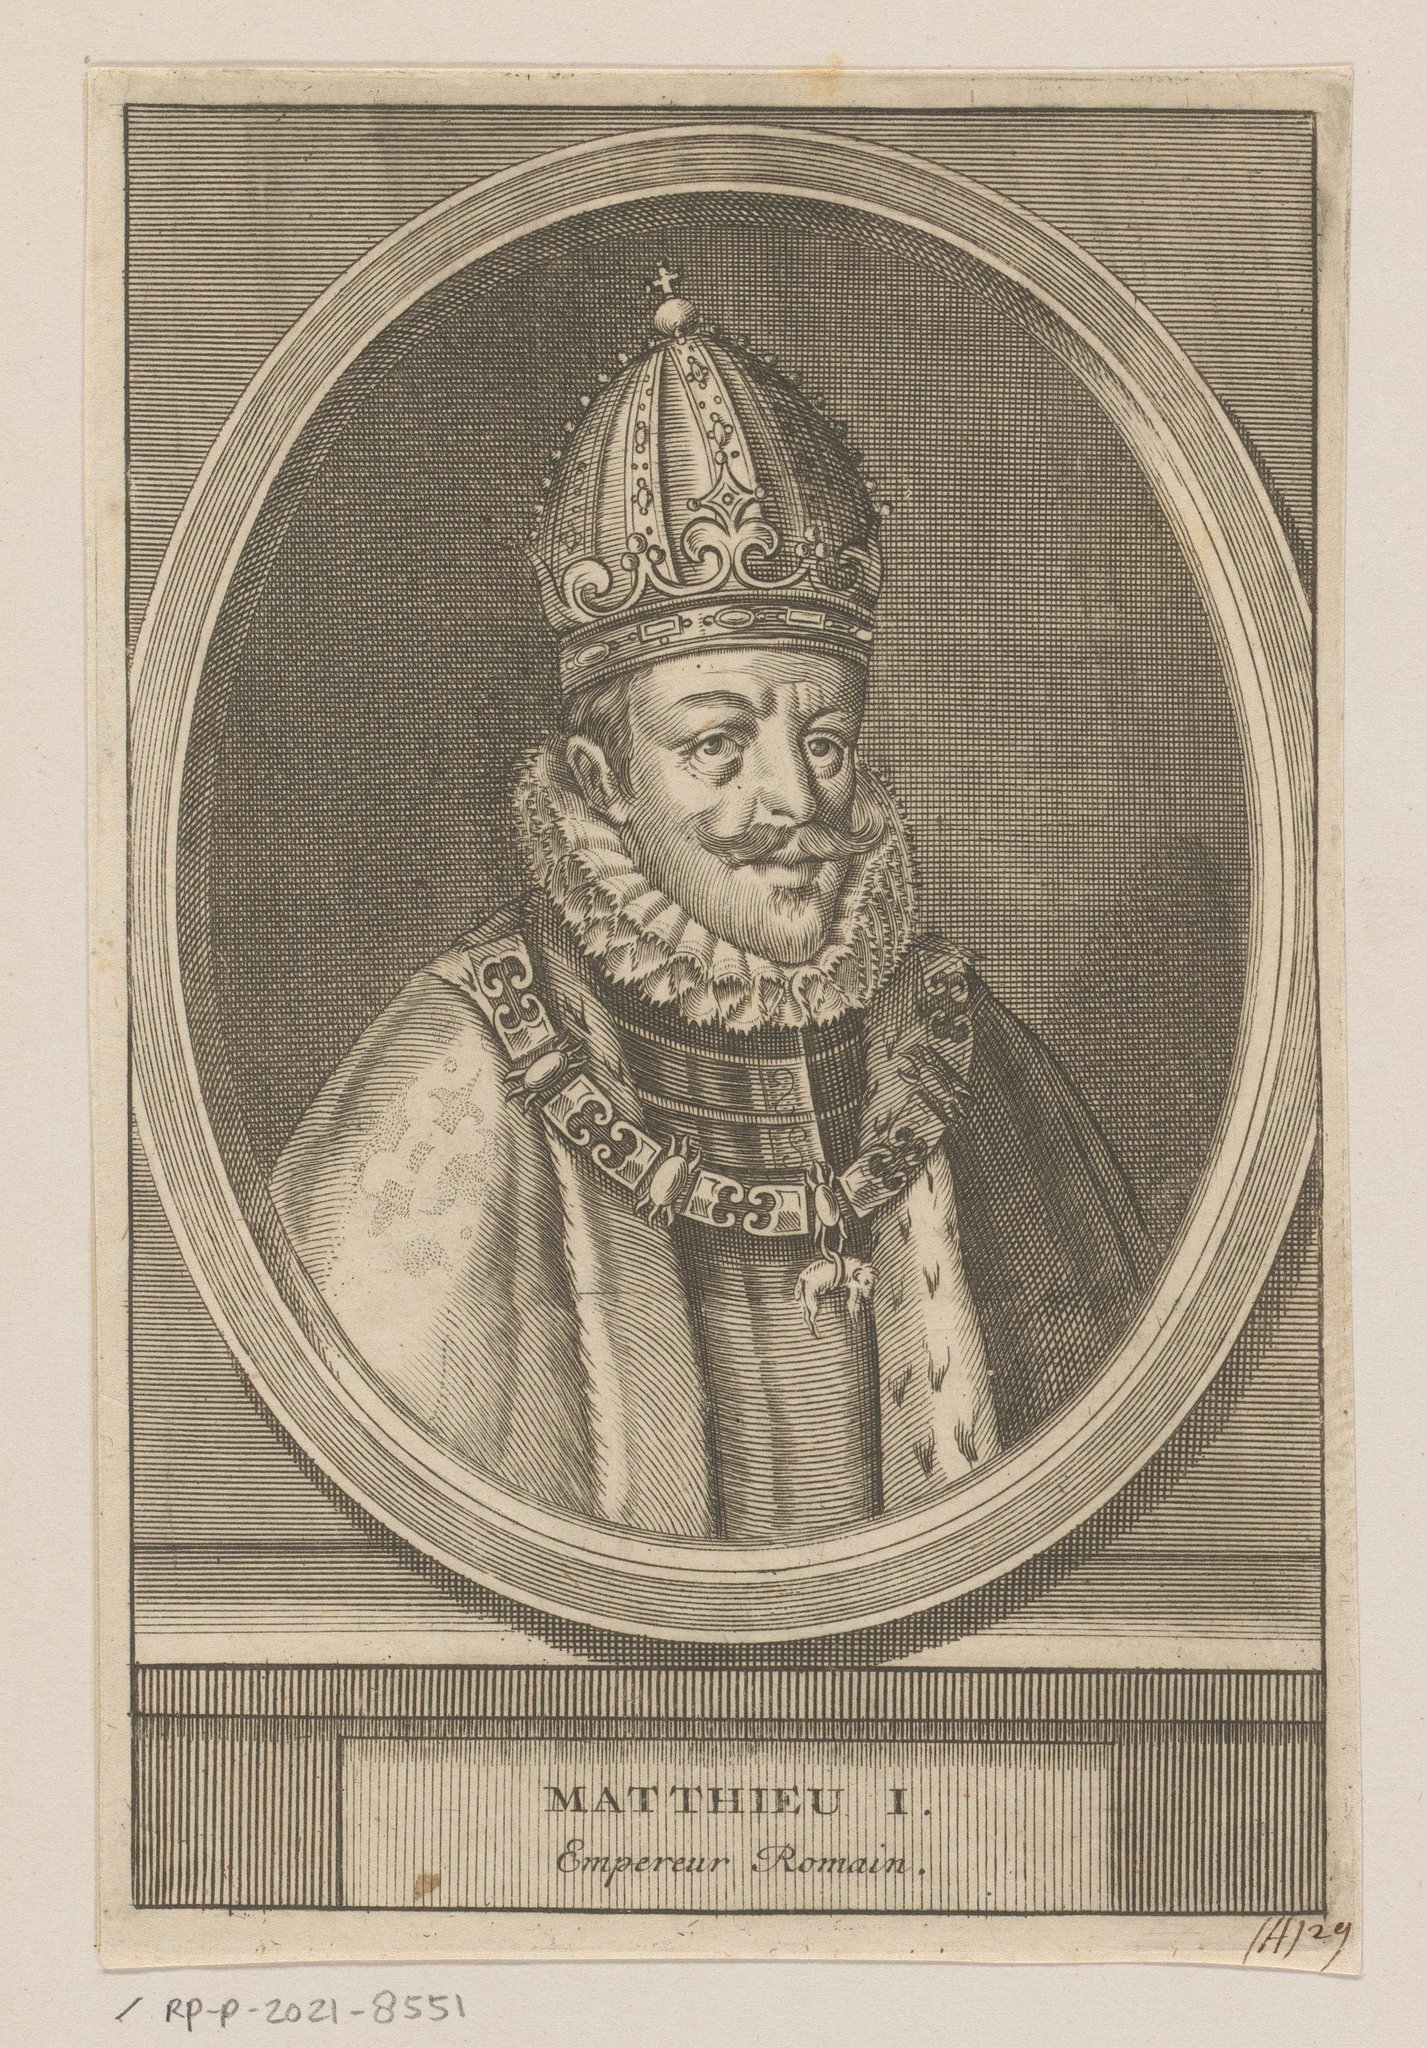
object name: print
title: Portret van keizer Matthias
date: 1729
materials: paper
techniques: engraving, etching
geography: northern netherlands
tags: vienna, matthias van oostenrijk (rooms-duits keizer), ornament ~ medallion, historical persons, knighthood order of the golden fleece, emperor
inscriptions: number: ‘(A)29’